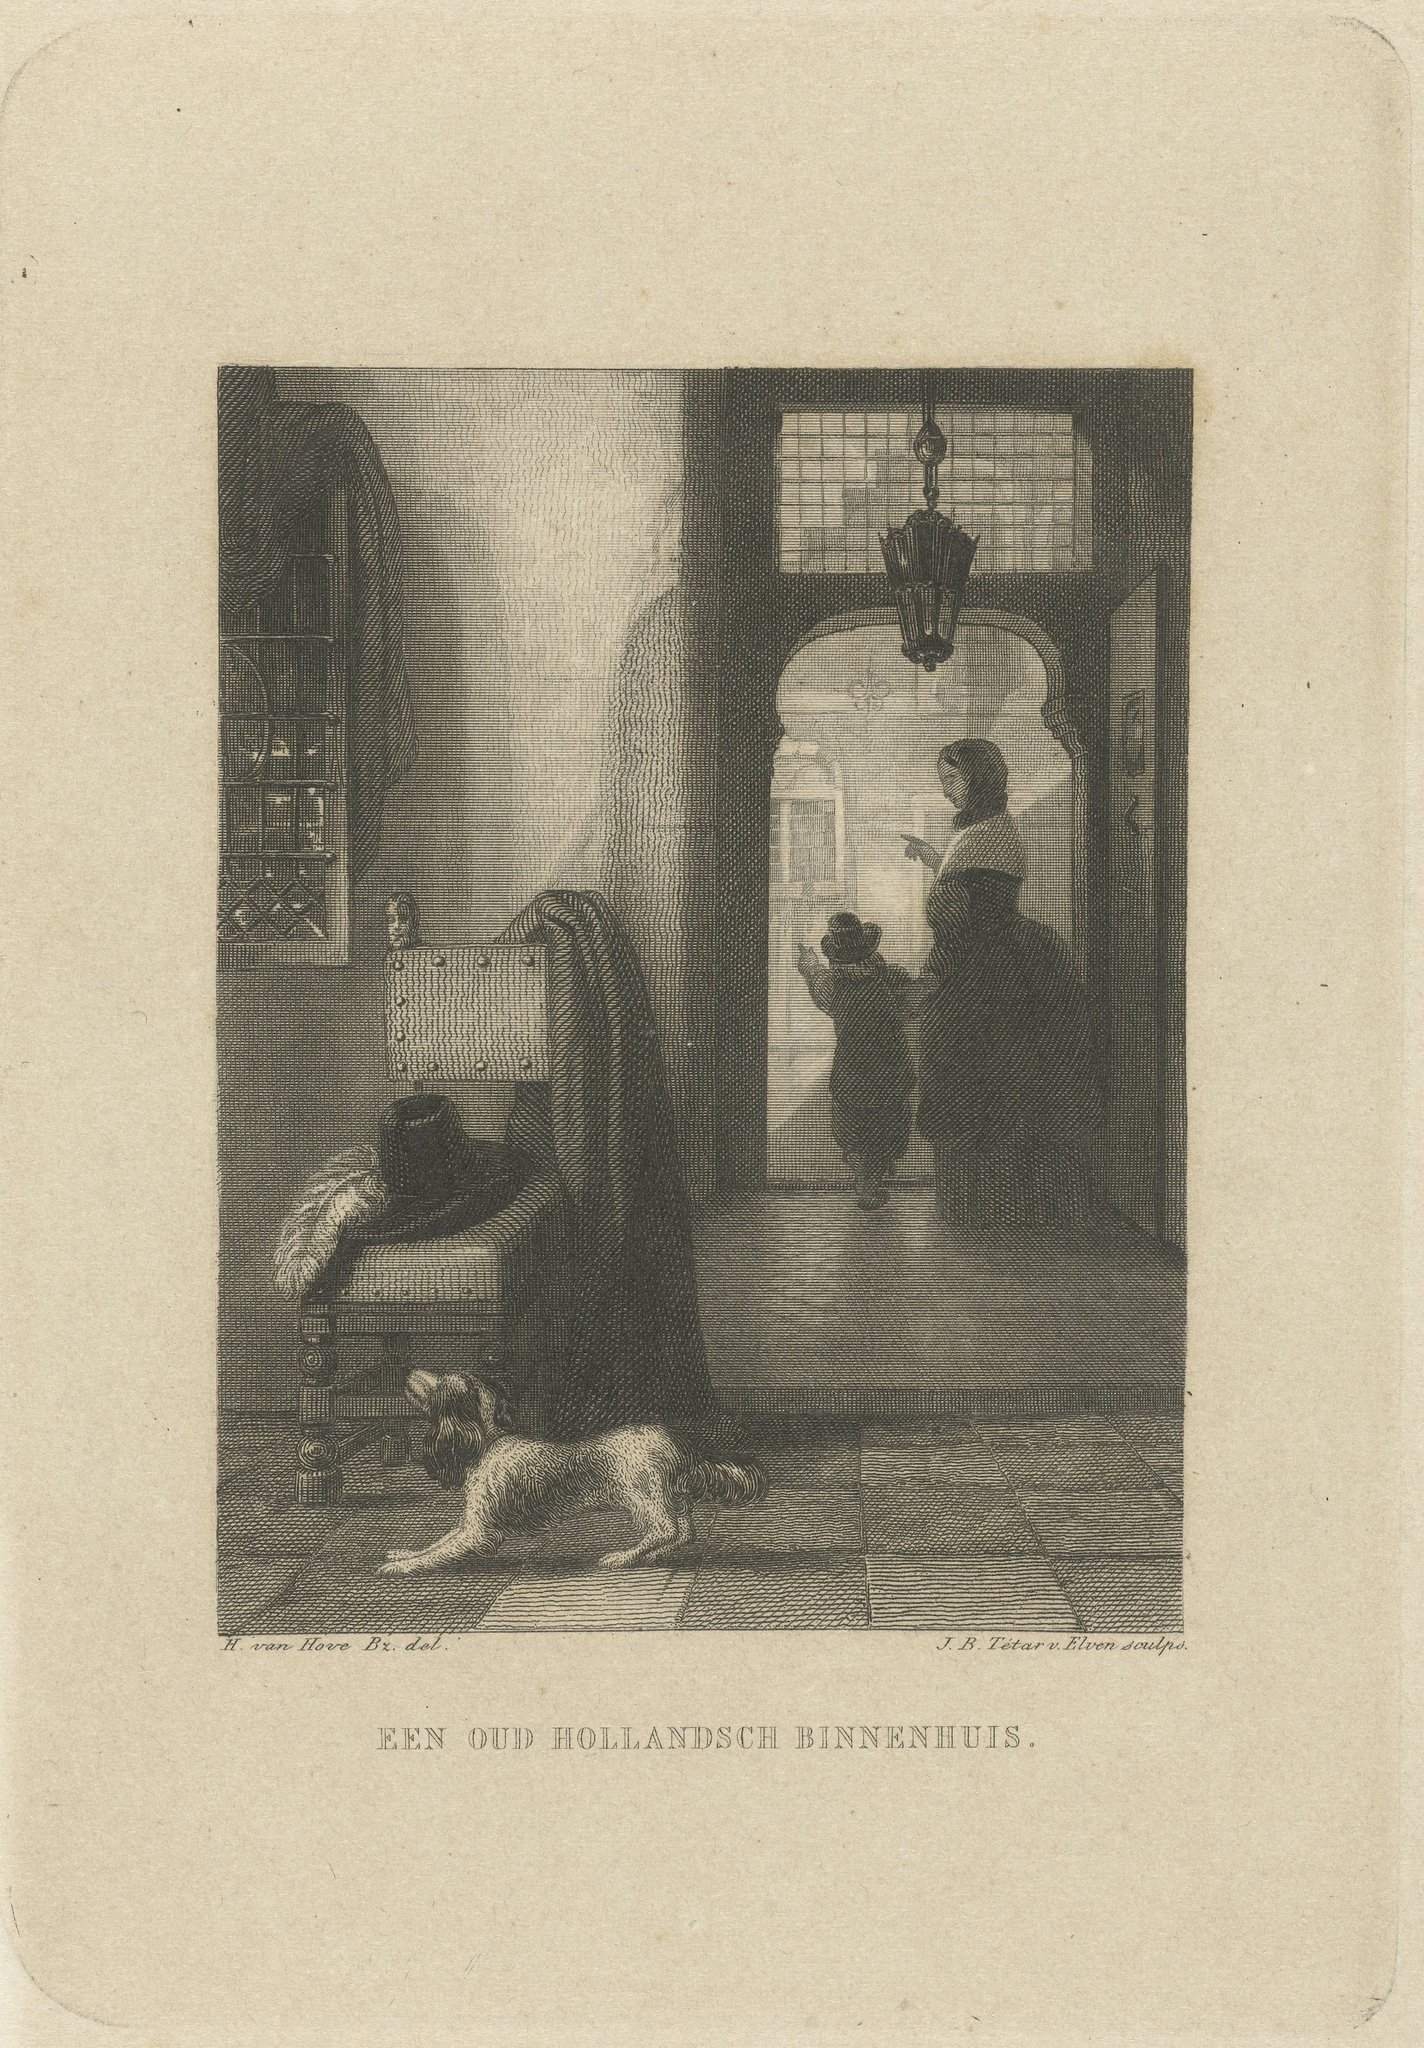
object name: print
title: EEN OUD HOLLANDSCH BINNENHUIS.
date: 1815-1889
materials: paper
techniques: engraving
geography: netherlands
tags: interior of the house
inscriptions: collector's mark: Lugt 2228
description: Interieur van een woning. Op een stoel ligt een hoed en over de rugleuning hangt een mantel. Een hond loert naar de veer van de hoed. In de deuropening op de achtergrond wijzen een moeder en kind naar buiten.